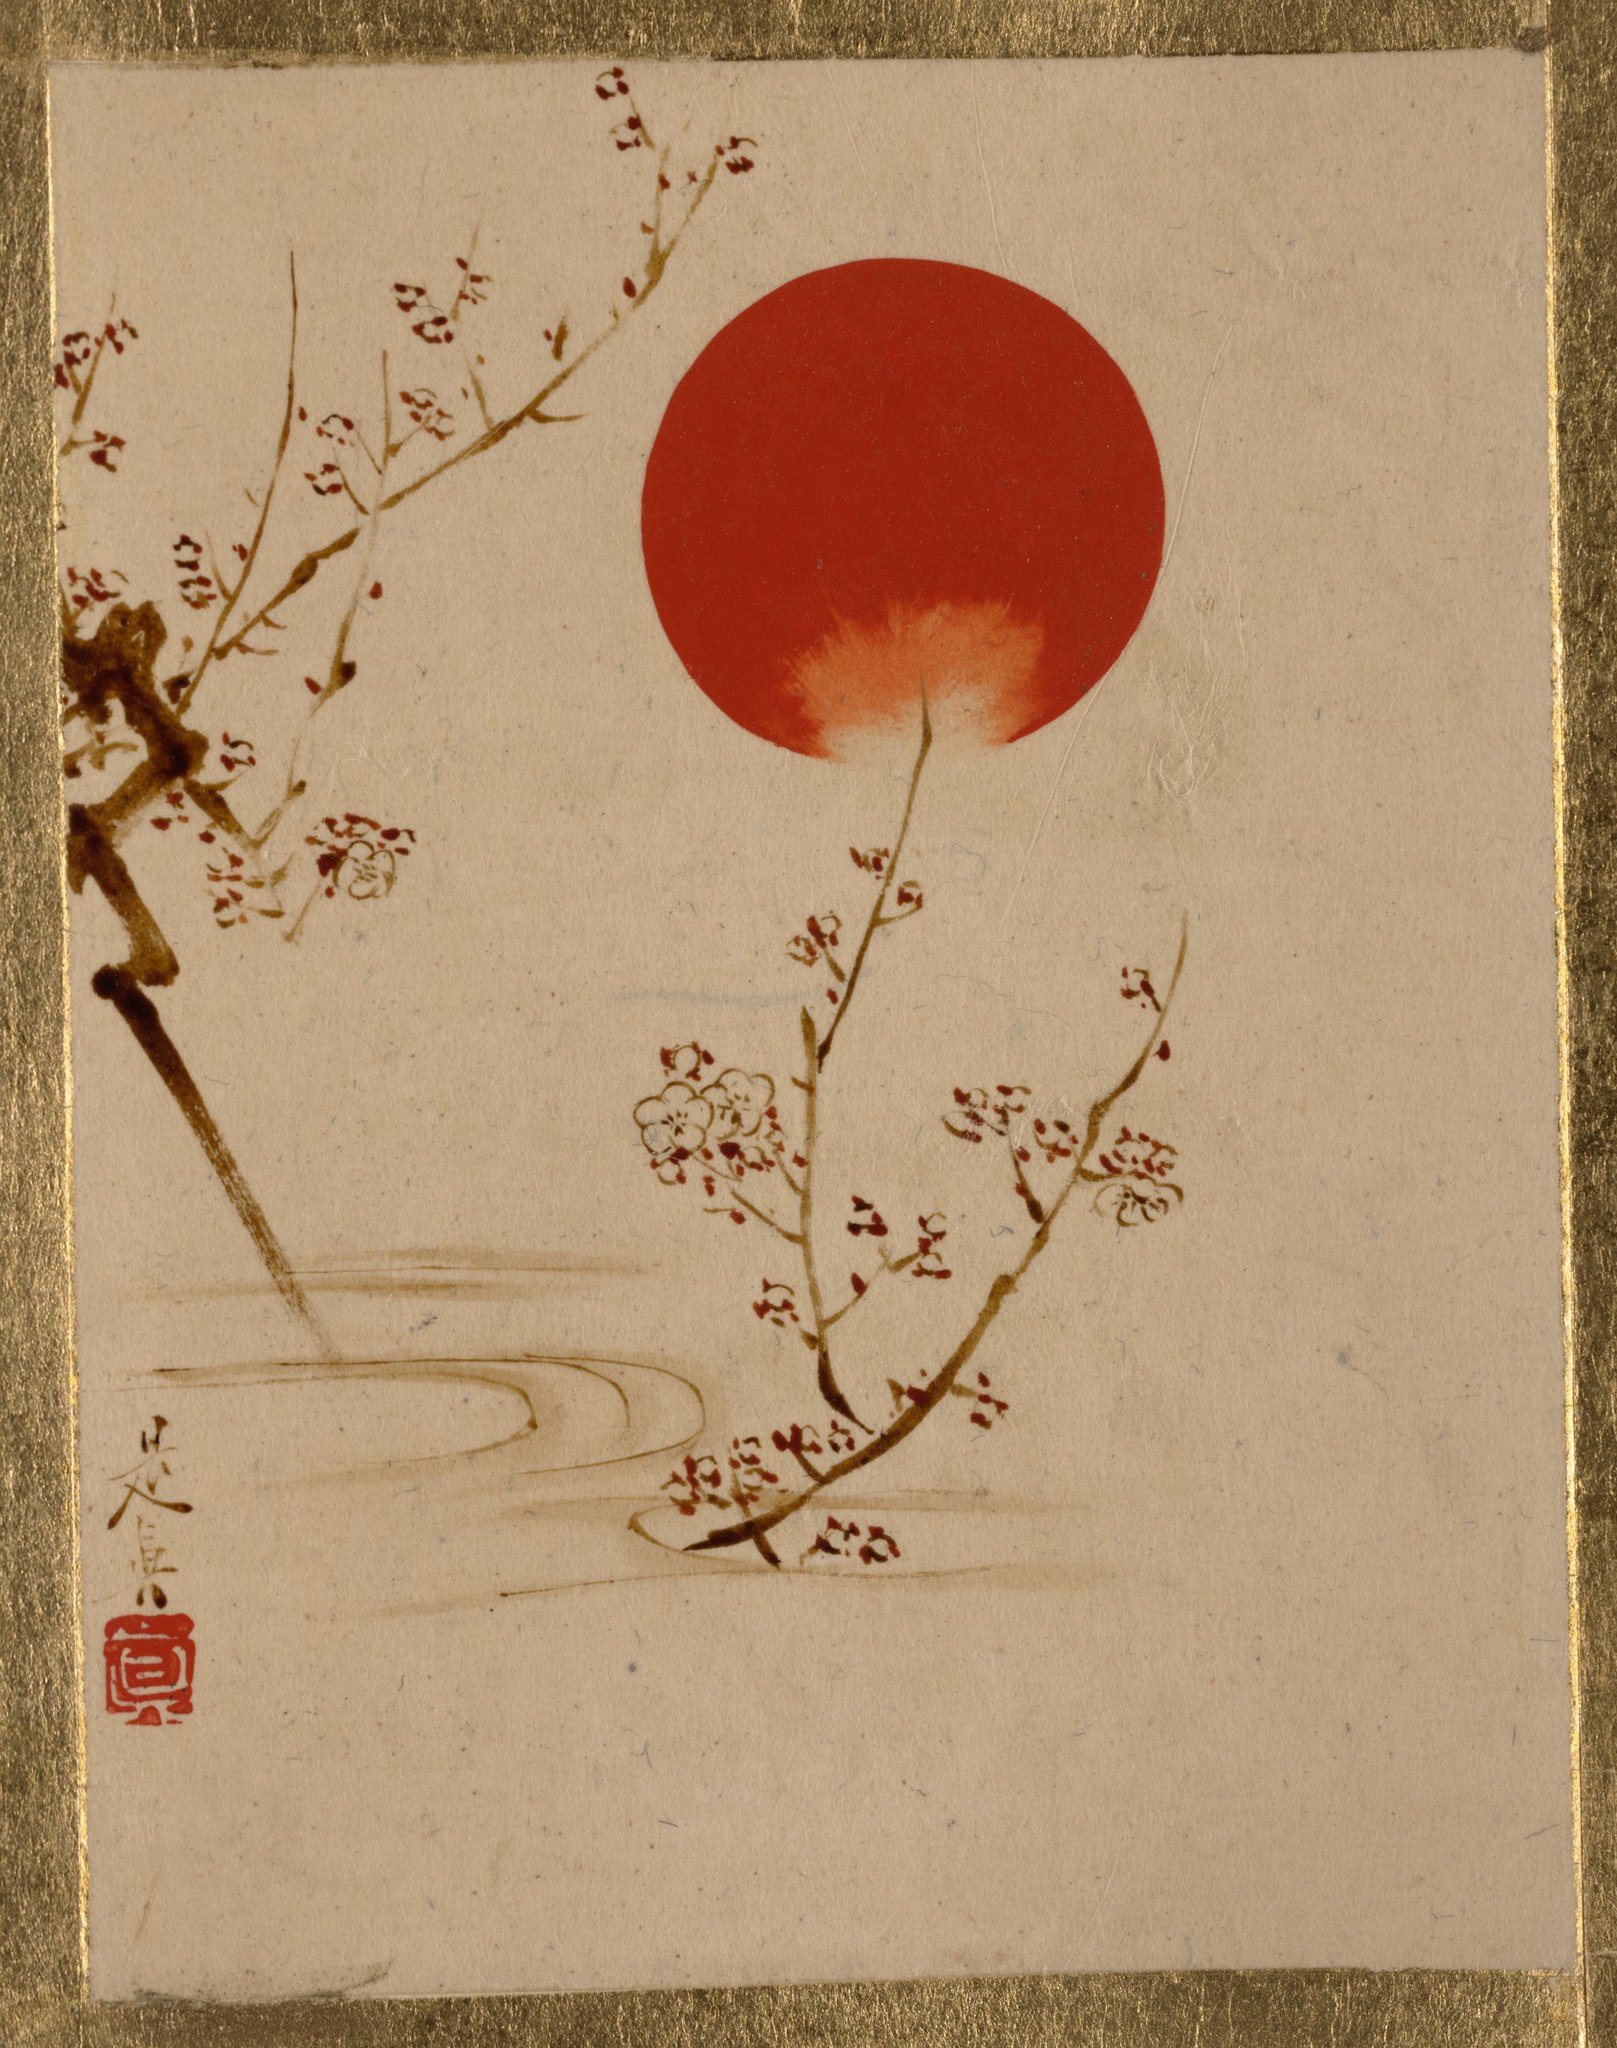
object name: album leaf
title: Sun and Plum Branches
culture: japanese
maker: shibata zeshin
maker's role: artist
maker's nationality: japanese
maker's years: 1807-1891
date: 1807-1868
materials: lacquer, paper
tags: sun,plants